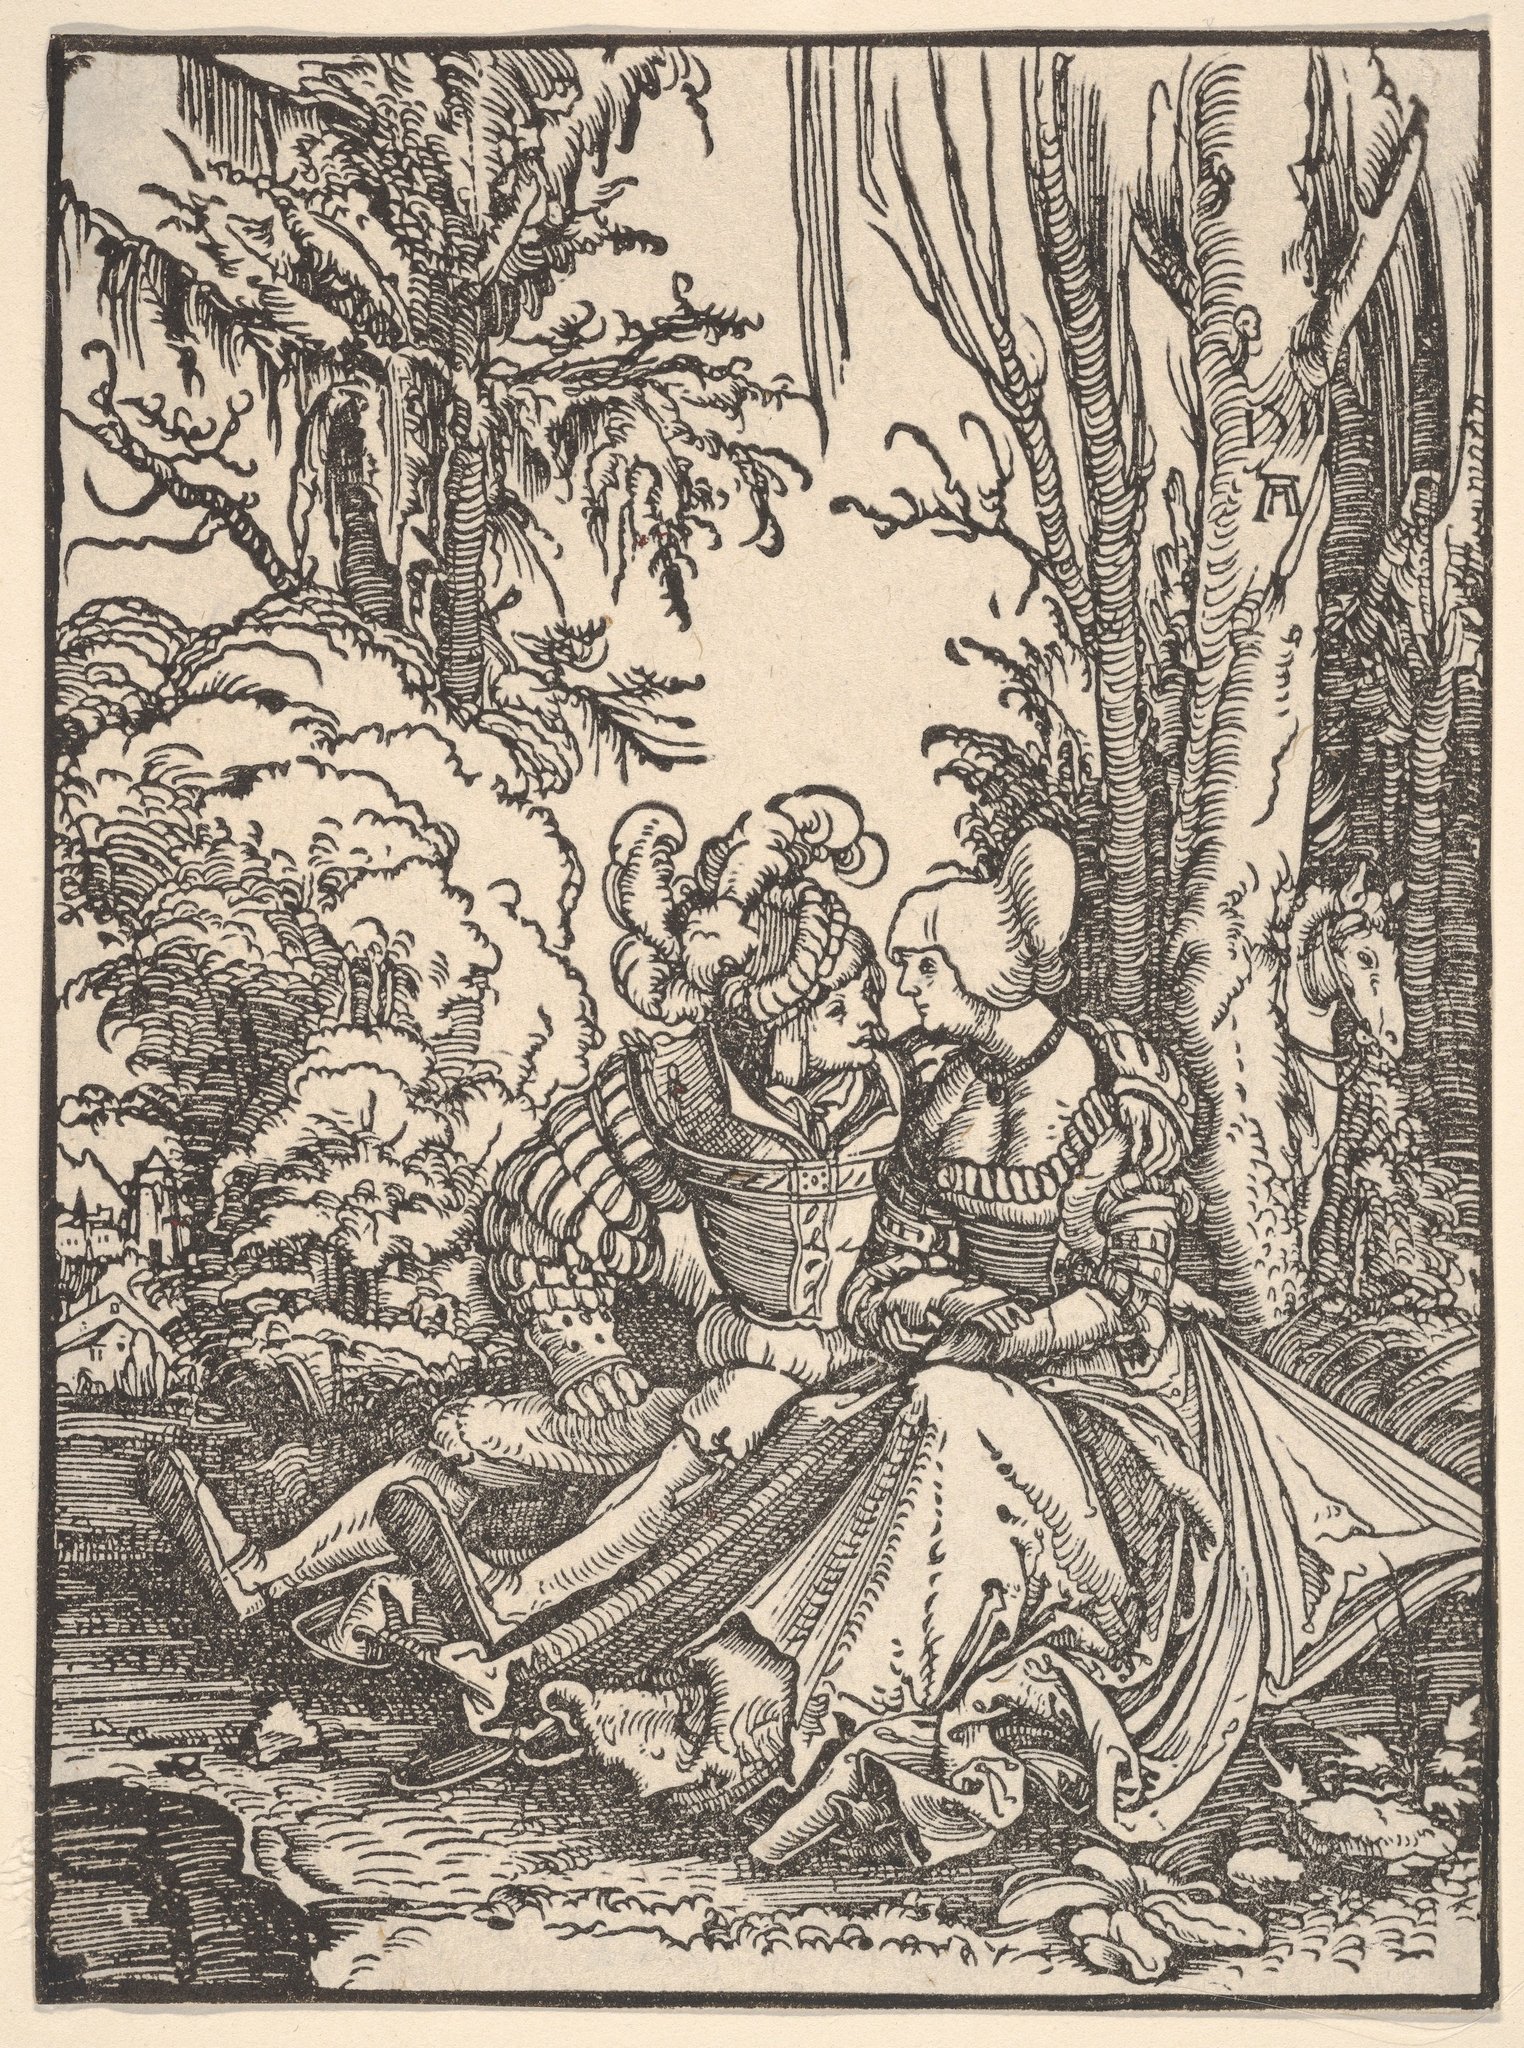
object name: print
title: Pair of Lovers in the Forest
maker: albrecht altdorfer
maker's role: artist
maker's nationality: german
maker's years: 1480-1538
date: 1511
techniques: woodcut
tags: men,lovers,women,forests